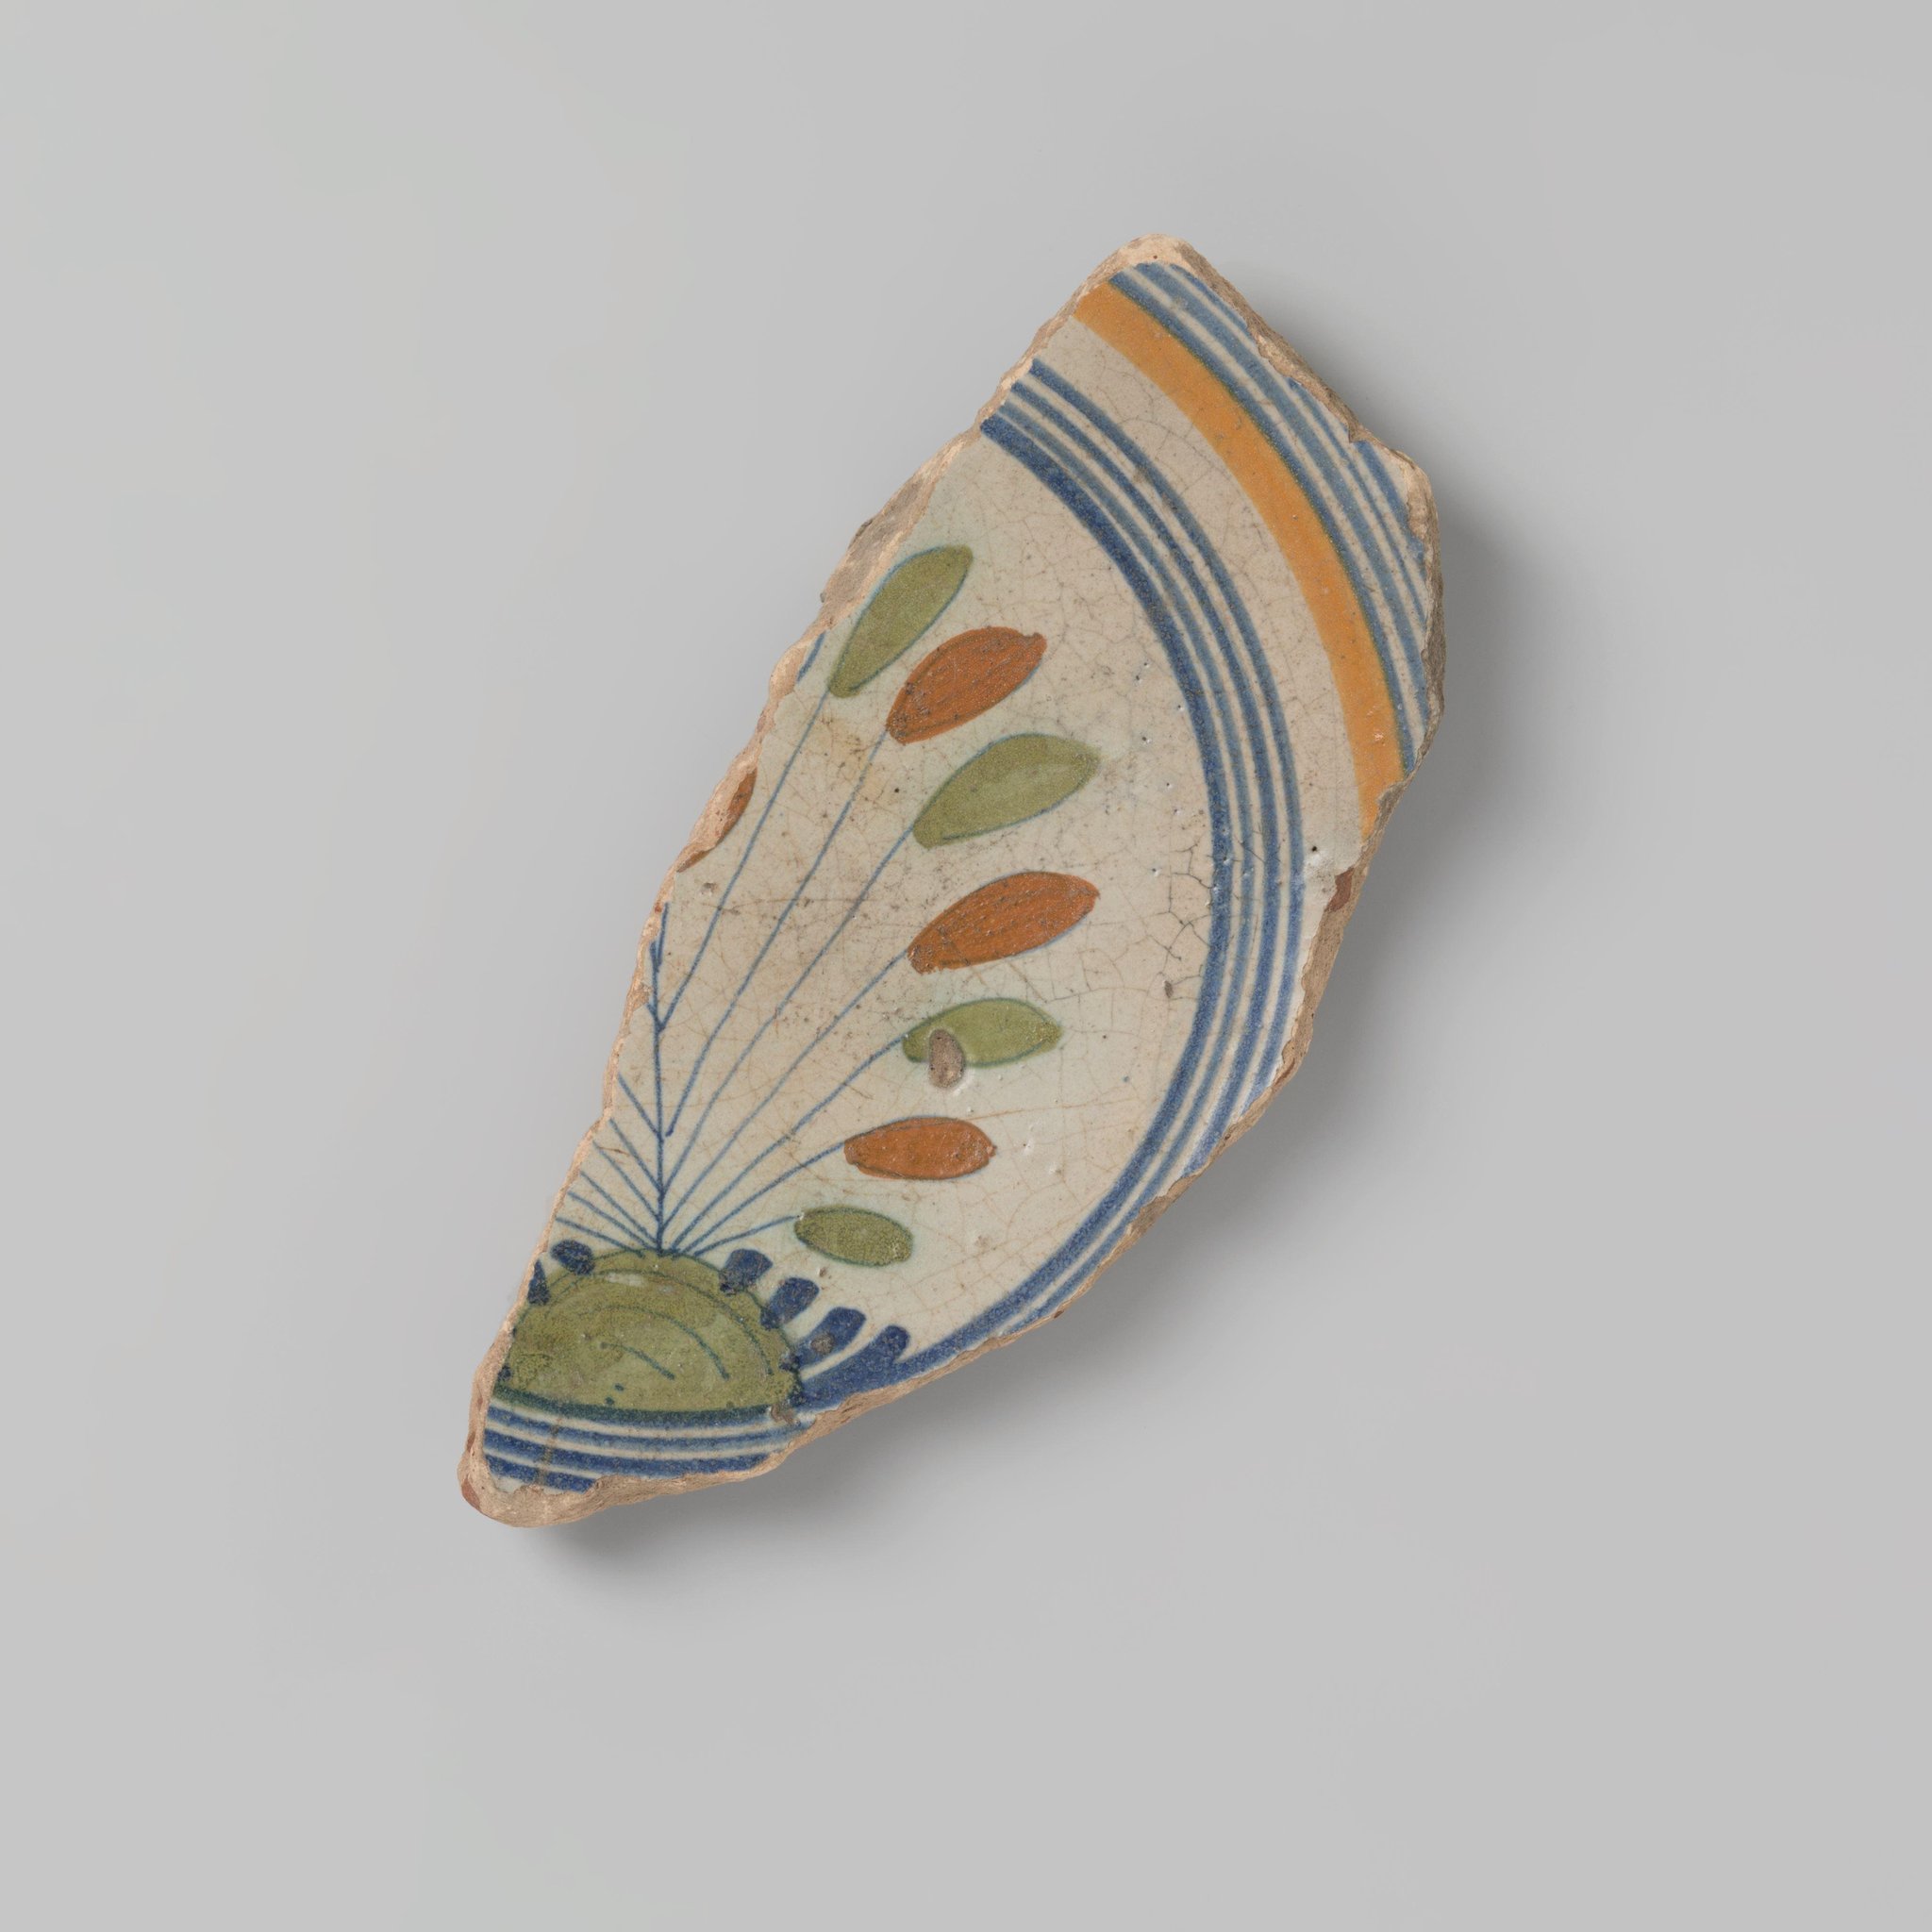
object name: sherd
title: Schotelscherf van aardewerk met veelkeleurige tekening van bloemen en een sierrand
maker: Anonymous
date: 1500-1799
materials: earthenware, glaze